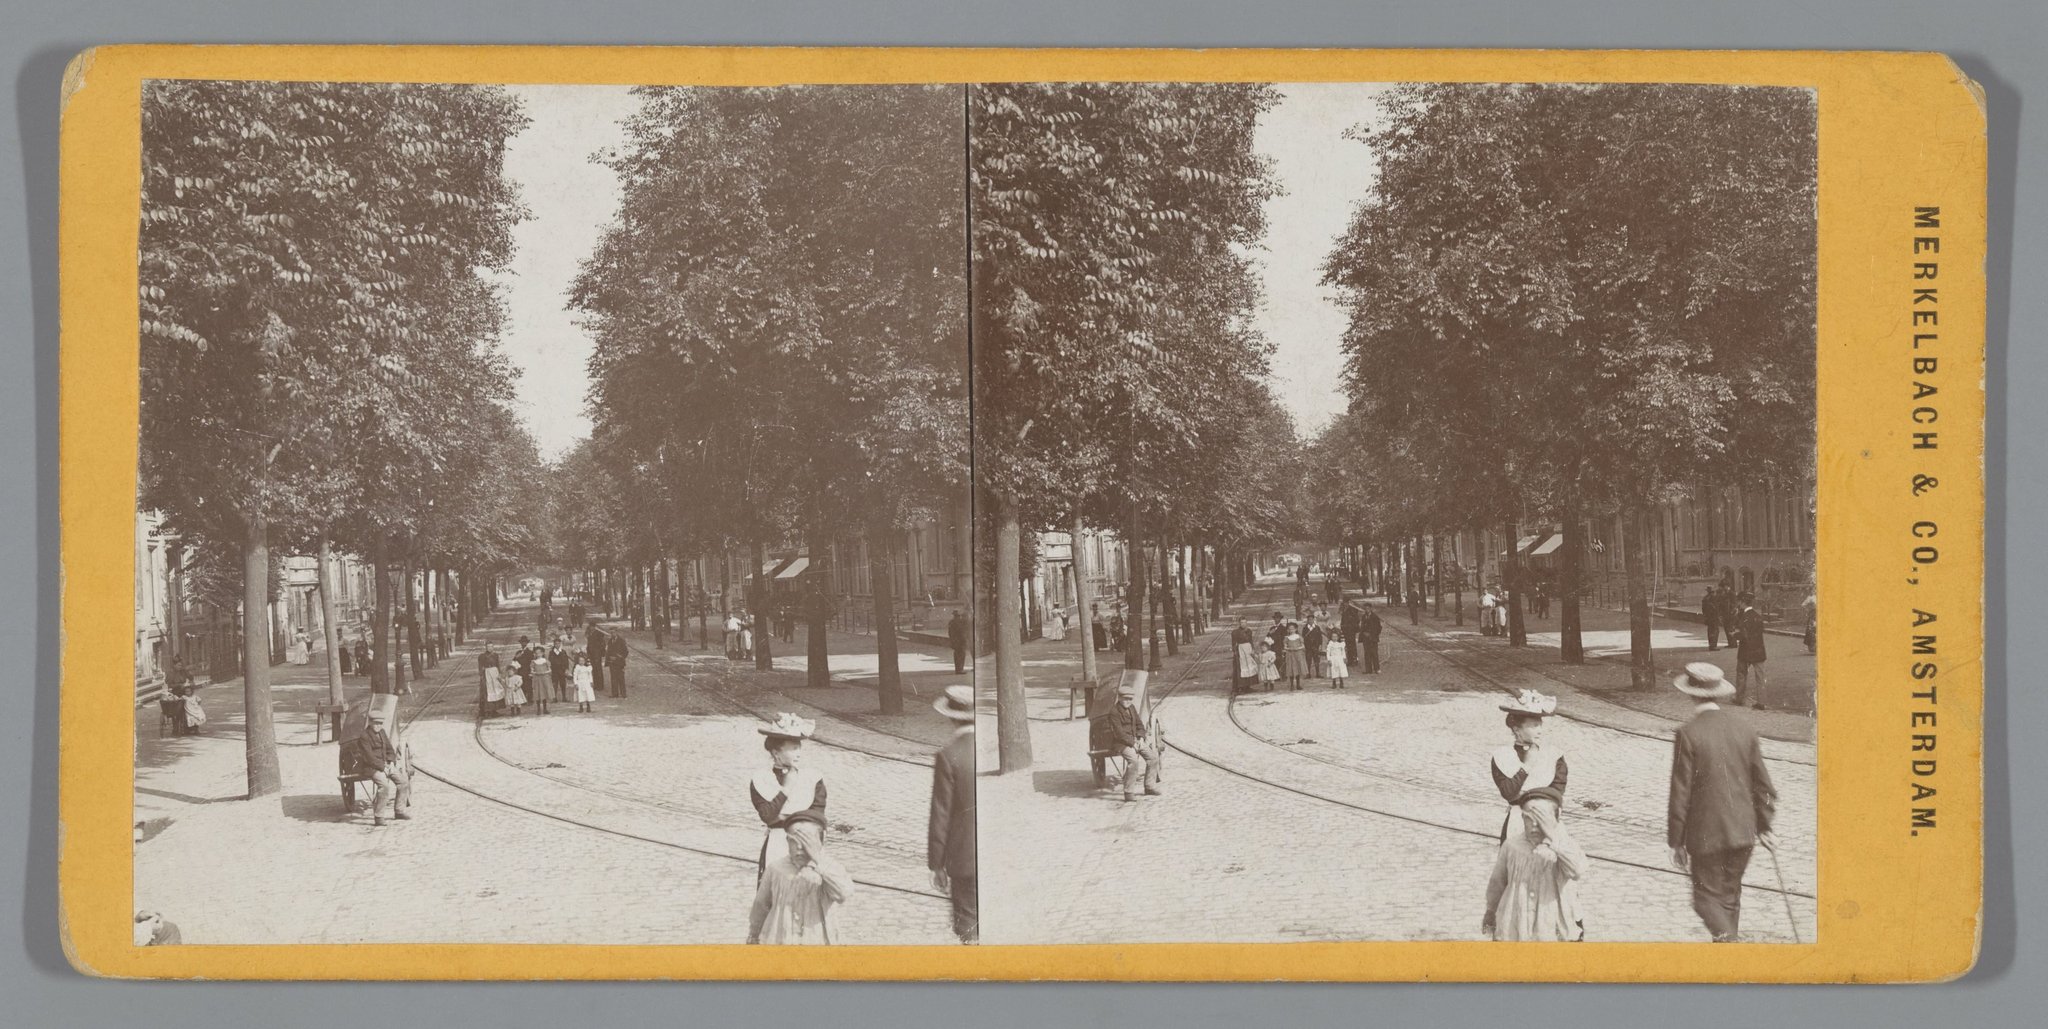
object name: stereograph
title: Plantage Middenlaan, Amsterdam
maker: Anonymous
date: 1877-1890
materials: paper, cardboard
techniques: collodion silver print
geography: amsterdam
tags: village street